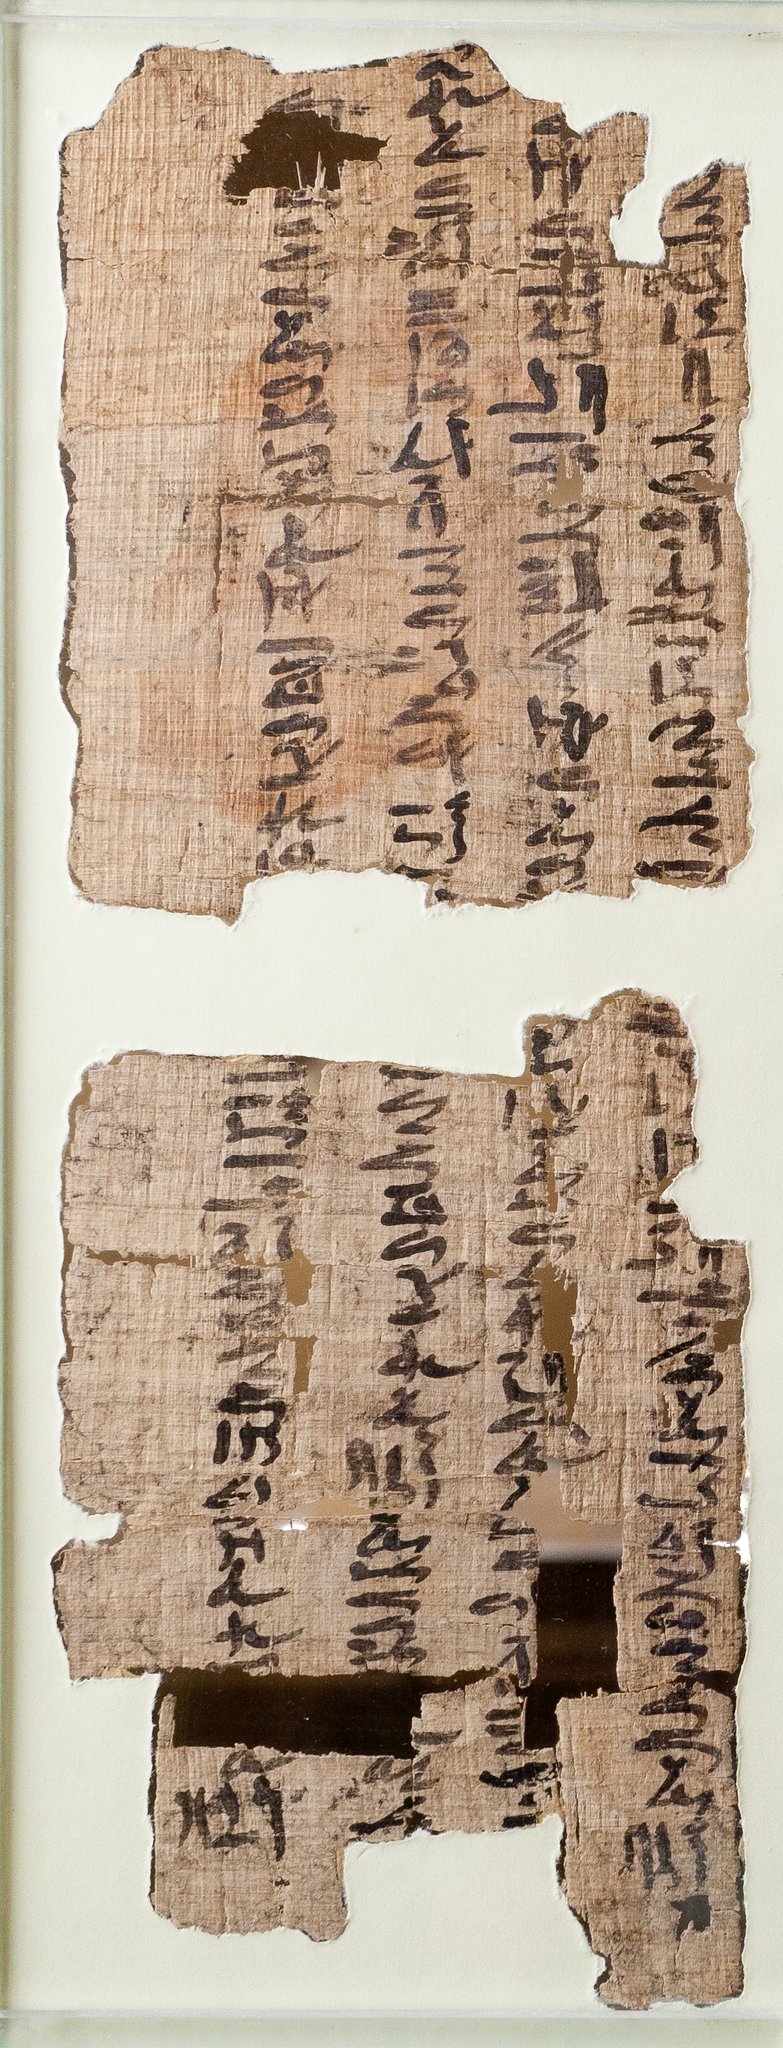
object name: papyrus, letter, heqanakht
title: Papyrus of Sitnebsekhtu, Heqanakht Letter IV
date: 1961-1917 BCE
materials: ink, papyrus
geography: egypt